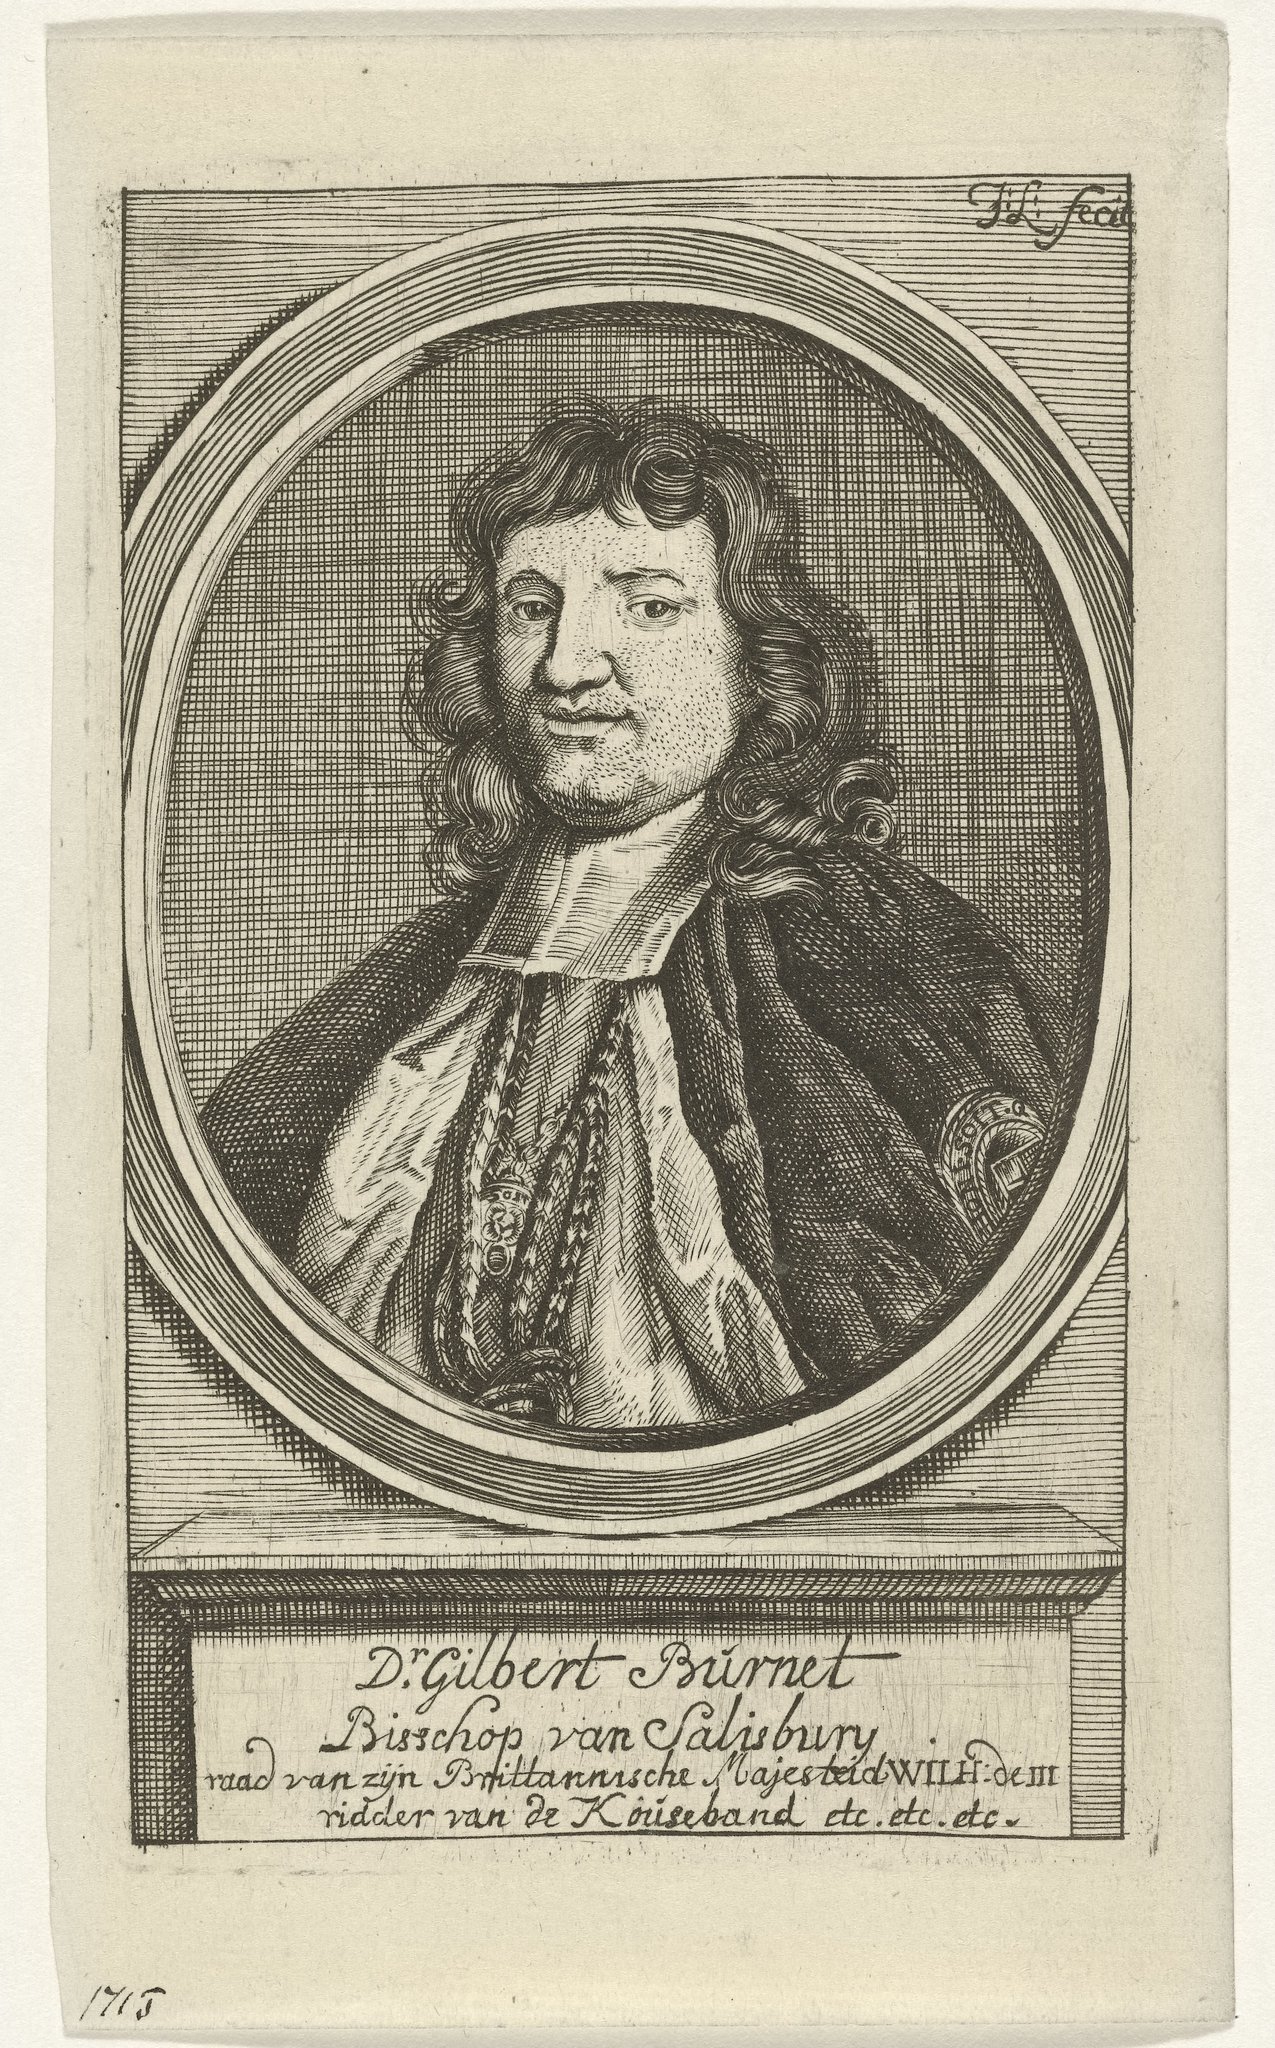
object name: print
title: Portret van Gilbert Burnet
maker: jan lamsvelt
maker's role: print maker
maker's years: 1674-1743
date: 1684-1743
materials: paper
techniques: engraving, etching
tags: clergyman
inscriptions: collector's mark: Lugt 2228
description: Portretbuste in ovaal naar links van Gilbert Burnet, bisschop van Salisbury, blootshoofds. Het portret steunt op een sokkel waarop de naam en titels van de geportretteerde staan.